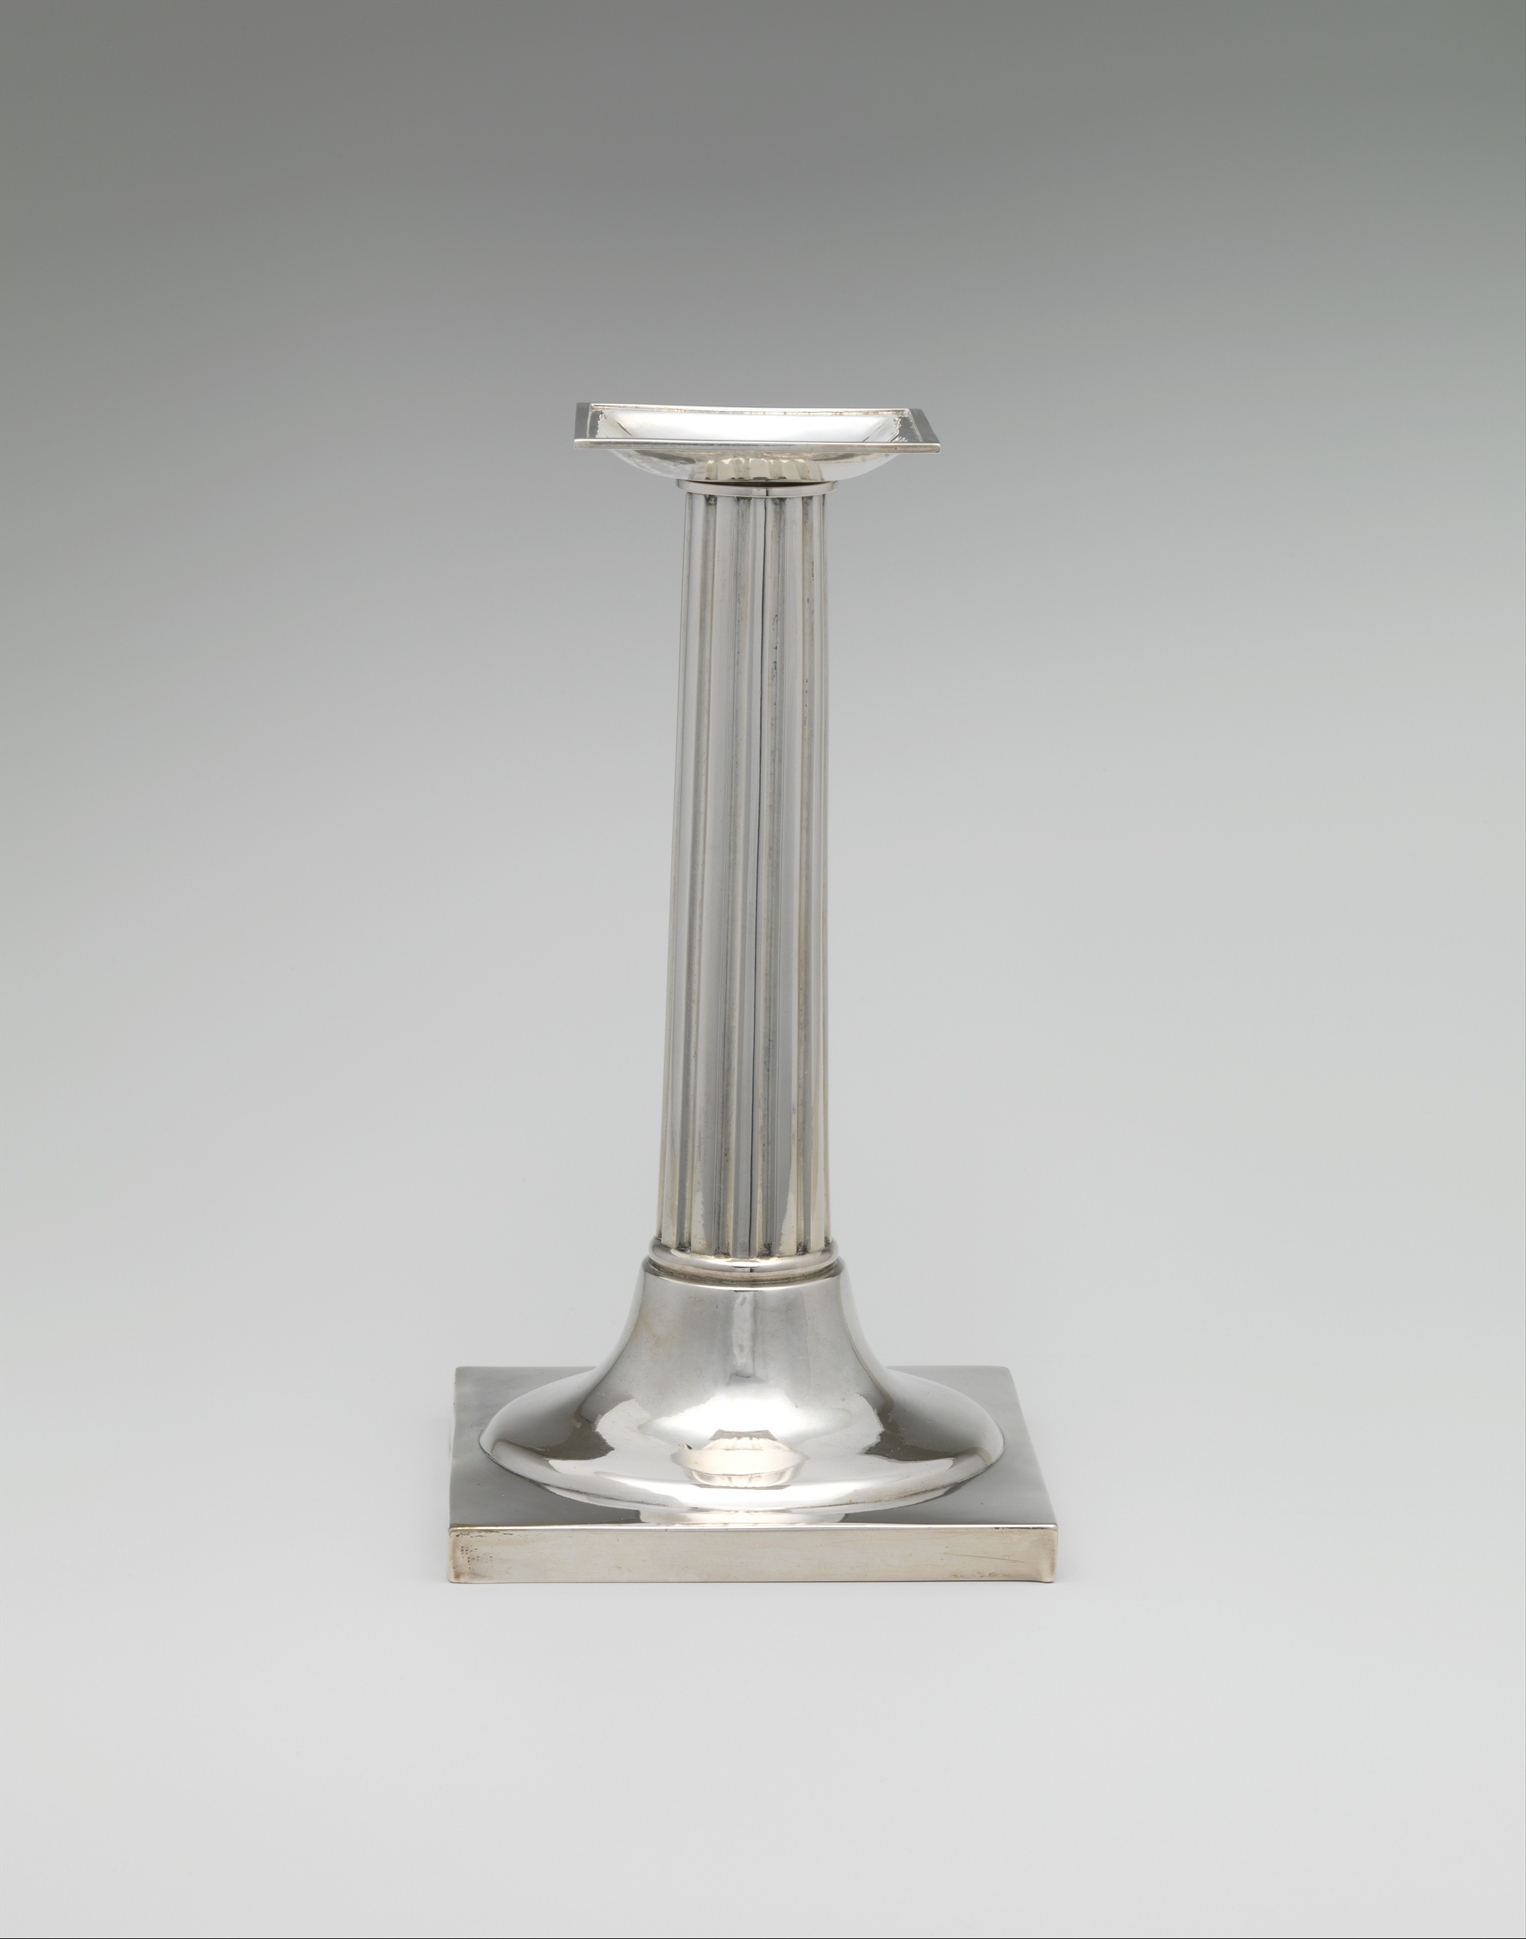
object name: candlestick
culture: american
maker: isaac hutton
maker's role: maker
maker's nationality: american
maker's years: 1766-1855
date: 1800-1815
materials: silver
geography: united states